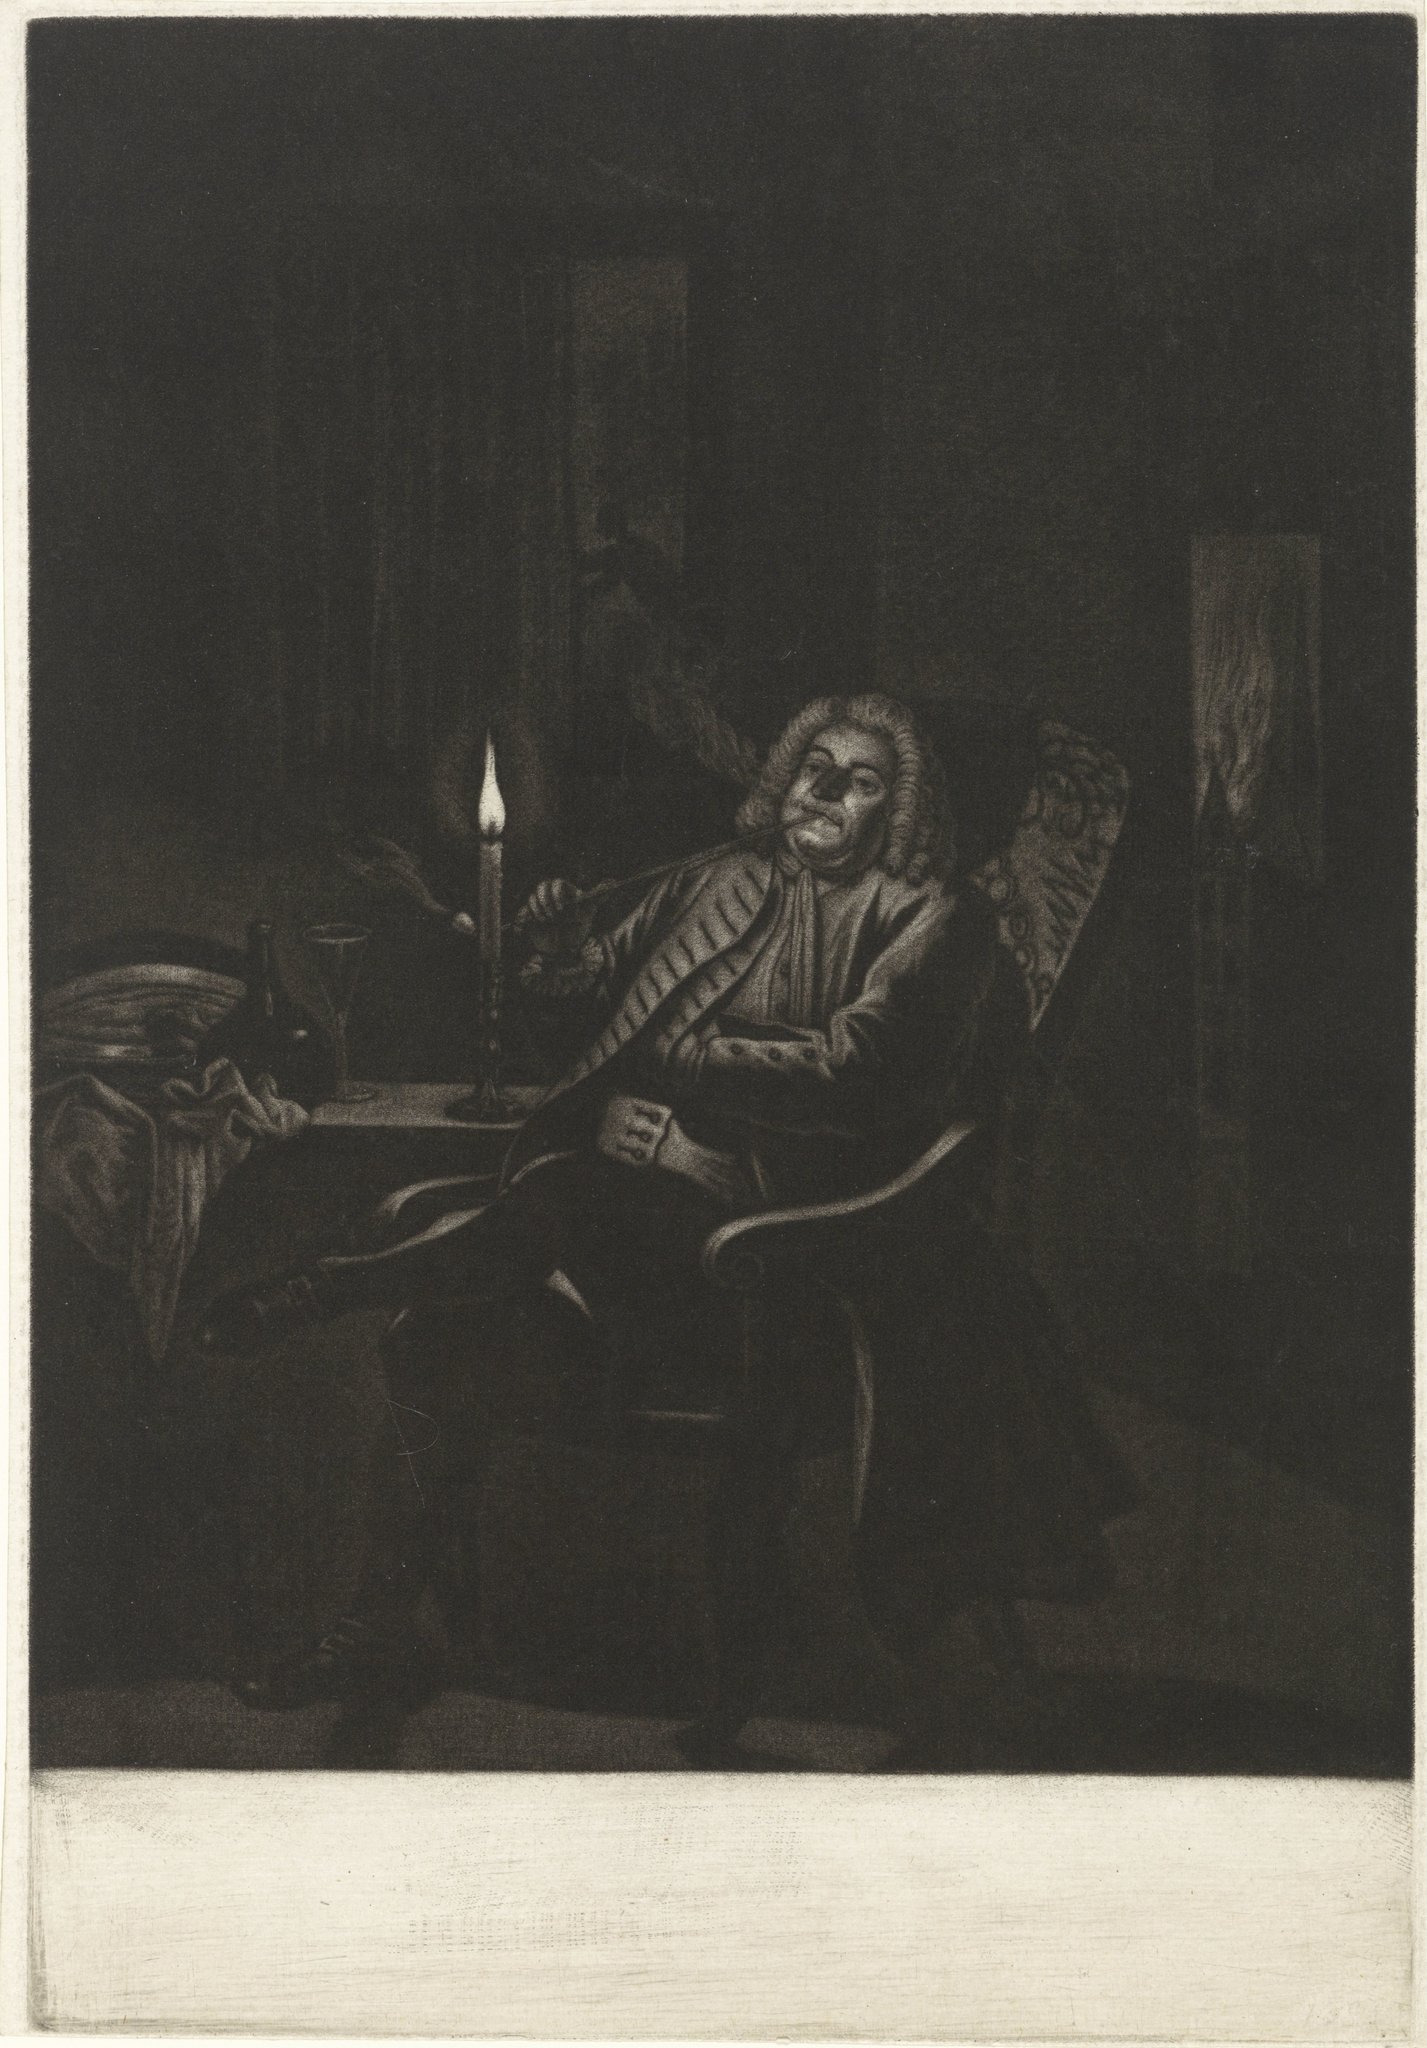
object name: print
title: Pijprokende man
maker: pieter louw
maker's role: draughtsman, print maker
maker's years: 1725-1800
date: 1743-1800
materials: paper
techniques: mezzotint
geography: amsterdam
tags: on fire, ablaze, pipe ~ tobacco, wig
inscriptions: collector's mark: Lugt 2228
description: In een vertrek zit een man pijp te roken bij kaarslicht. Door de deur zijn brandende huizen te zien en door het venster een vluchtende man.